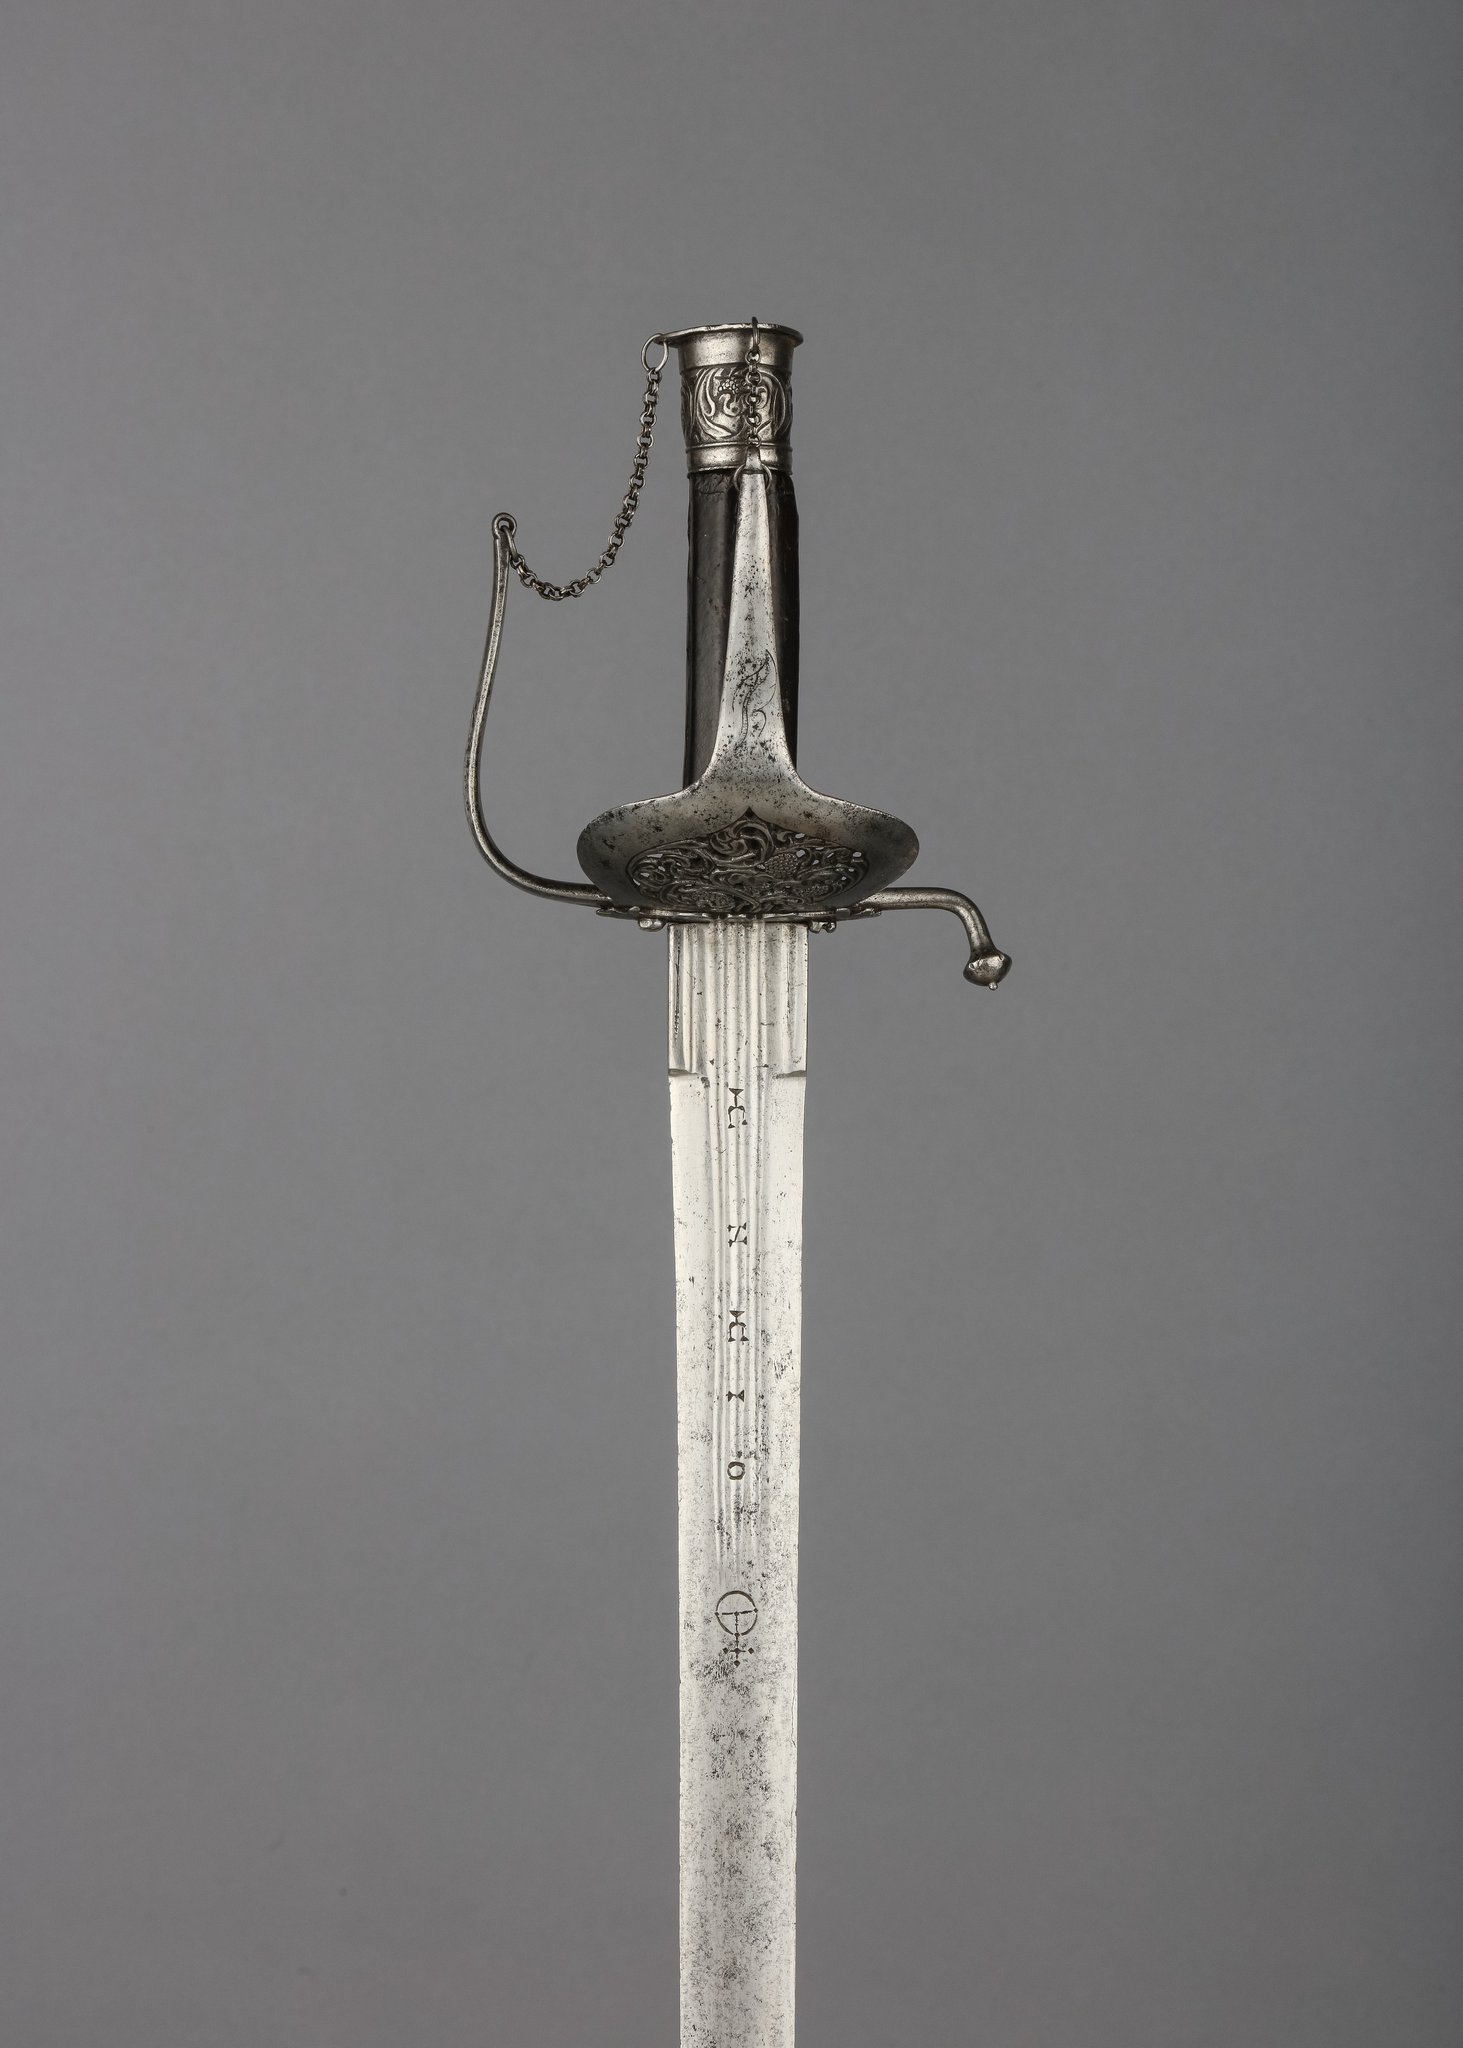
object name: small sword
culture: italian or spanish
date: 1700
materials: leather, steel, wood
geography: germany